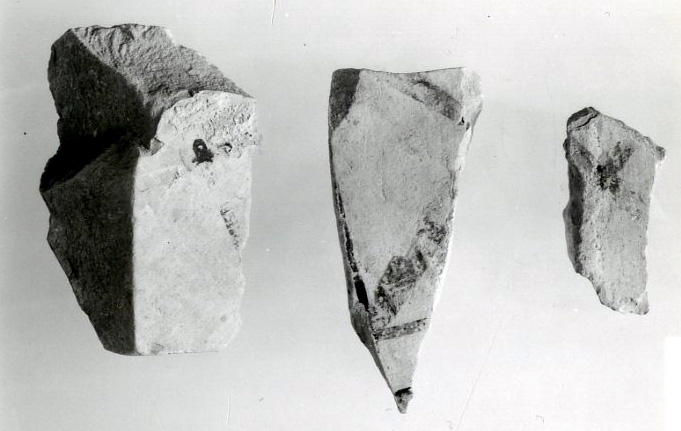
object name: relief fragment, tomb of meketre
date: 1981-1975 BCE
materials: limestone, paint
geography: egypt